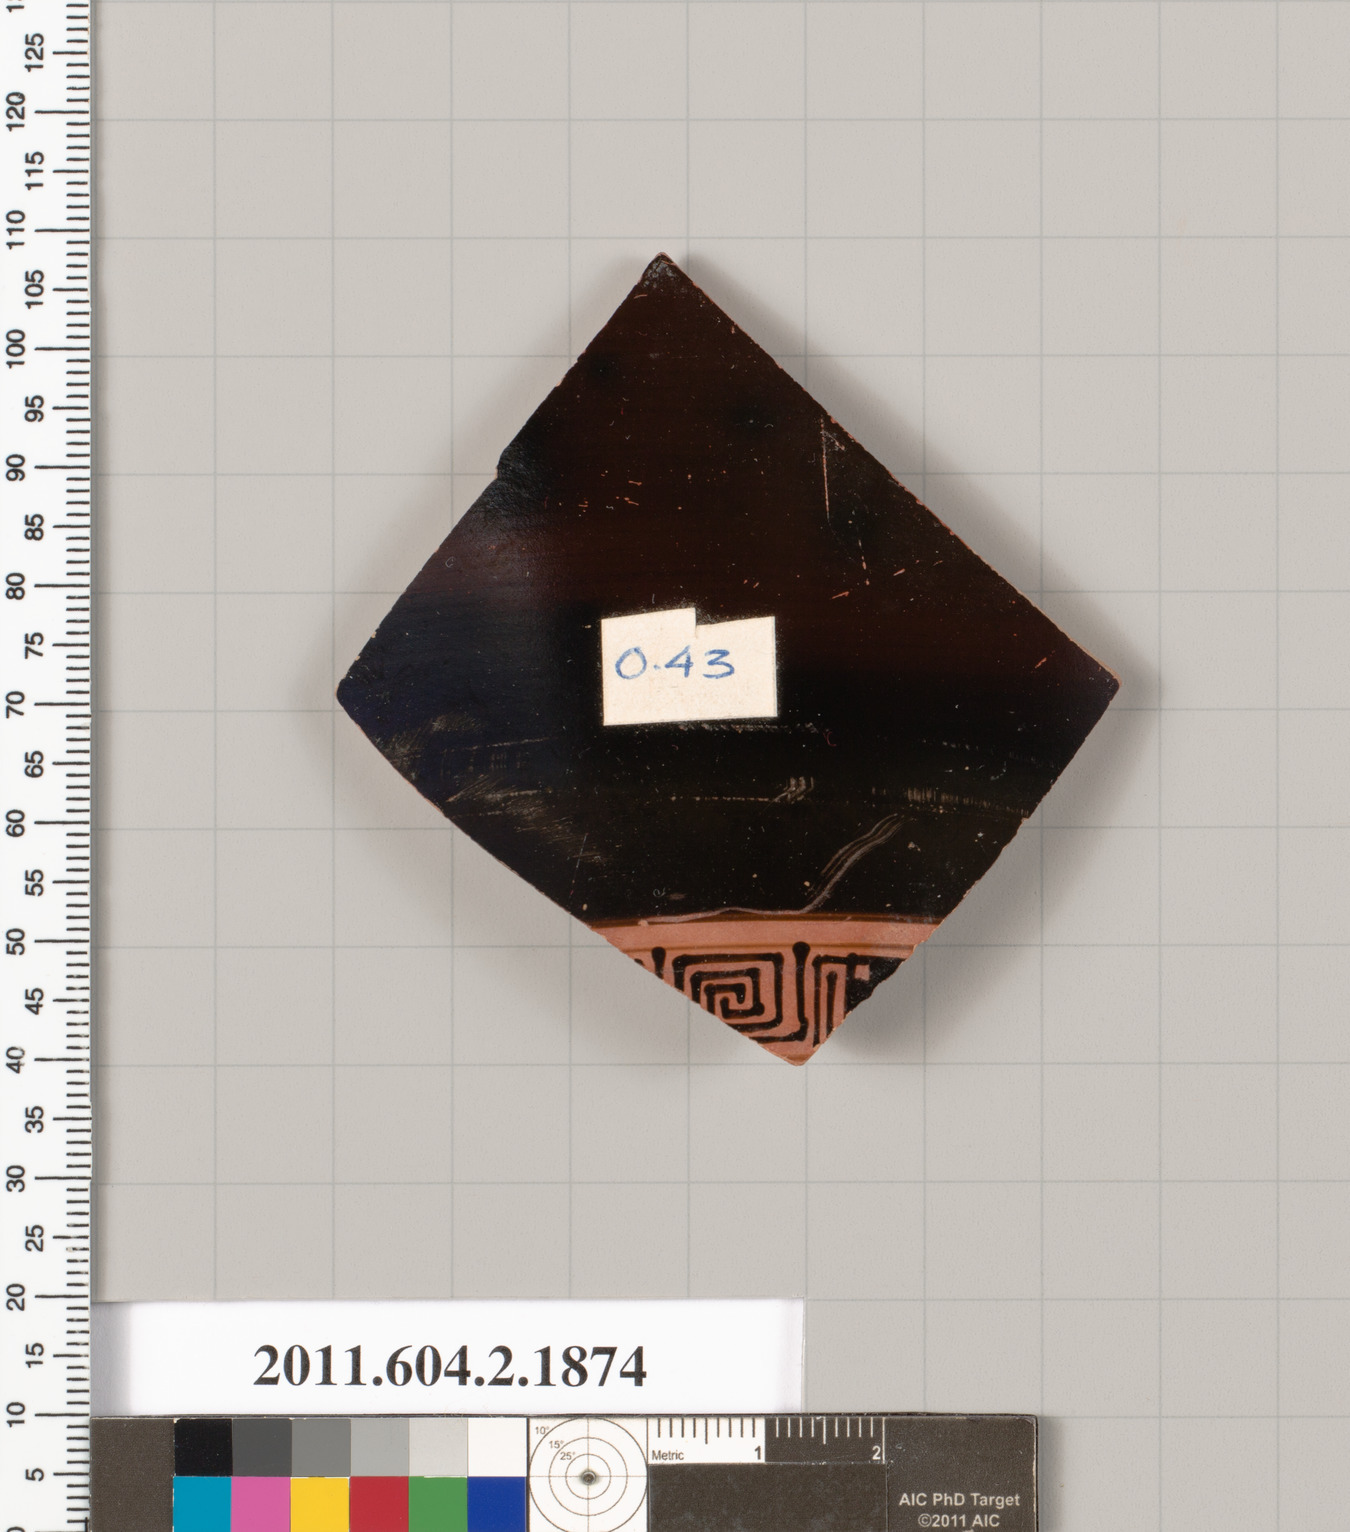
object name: skyphos fragment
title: Terracotta fragment of a skyphos (deep drinking cup)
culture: greek, attic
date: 470-450 BCE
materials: terracotta